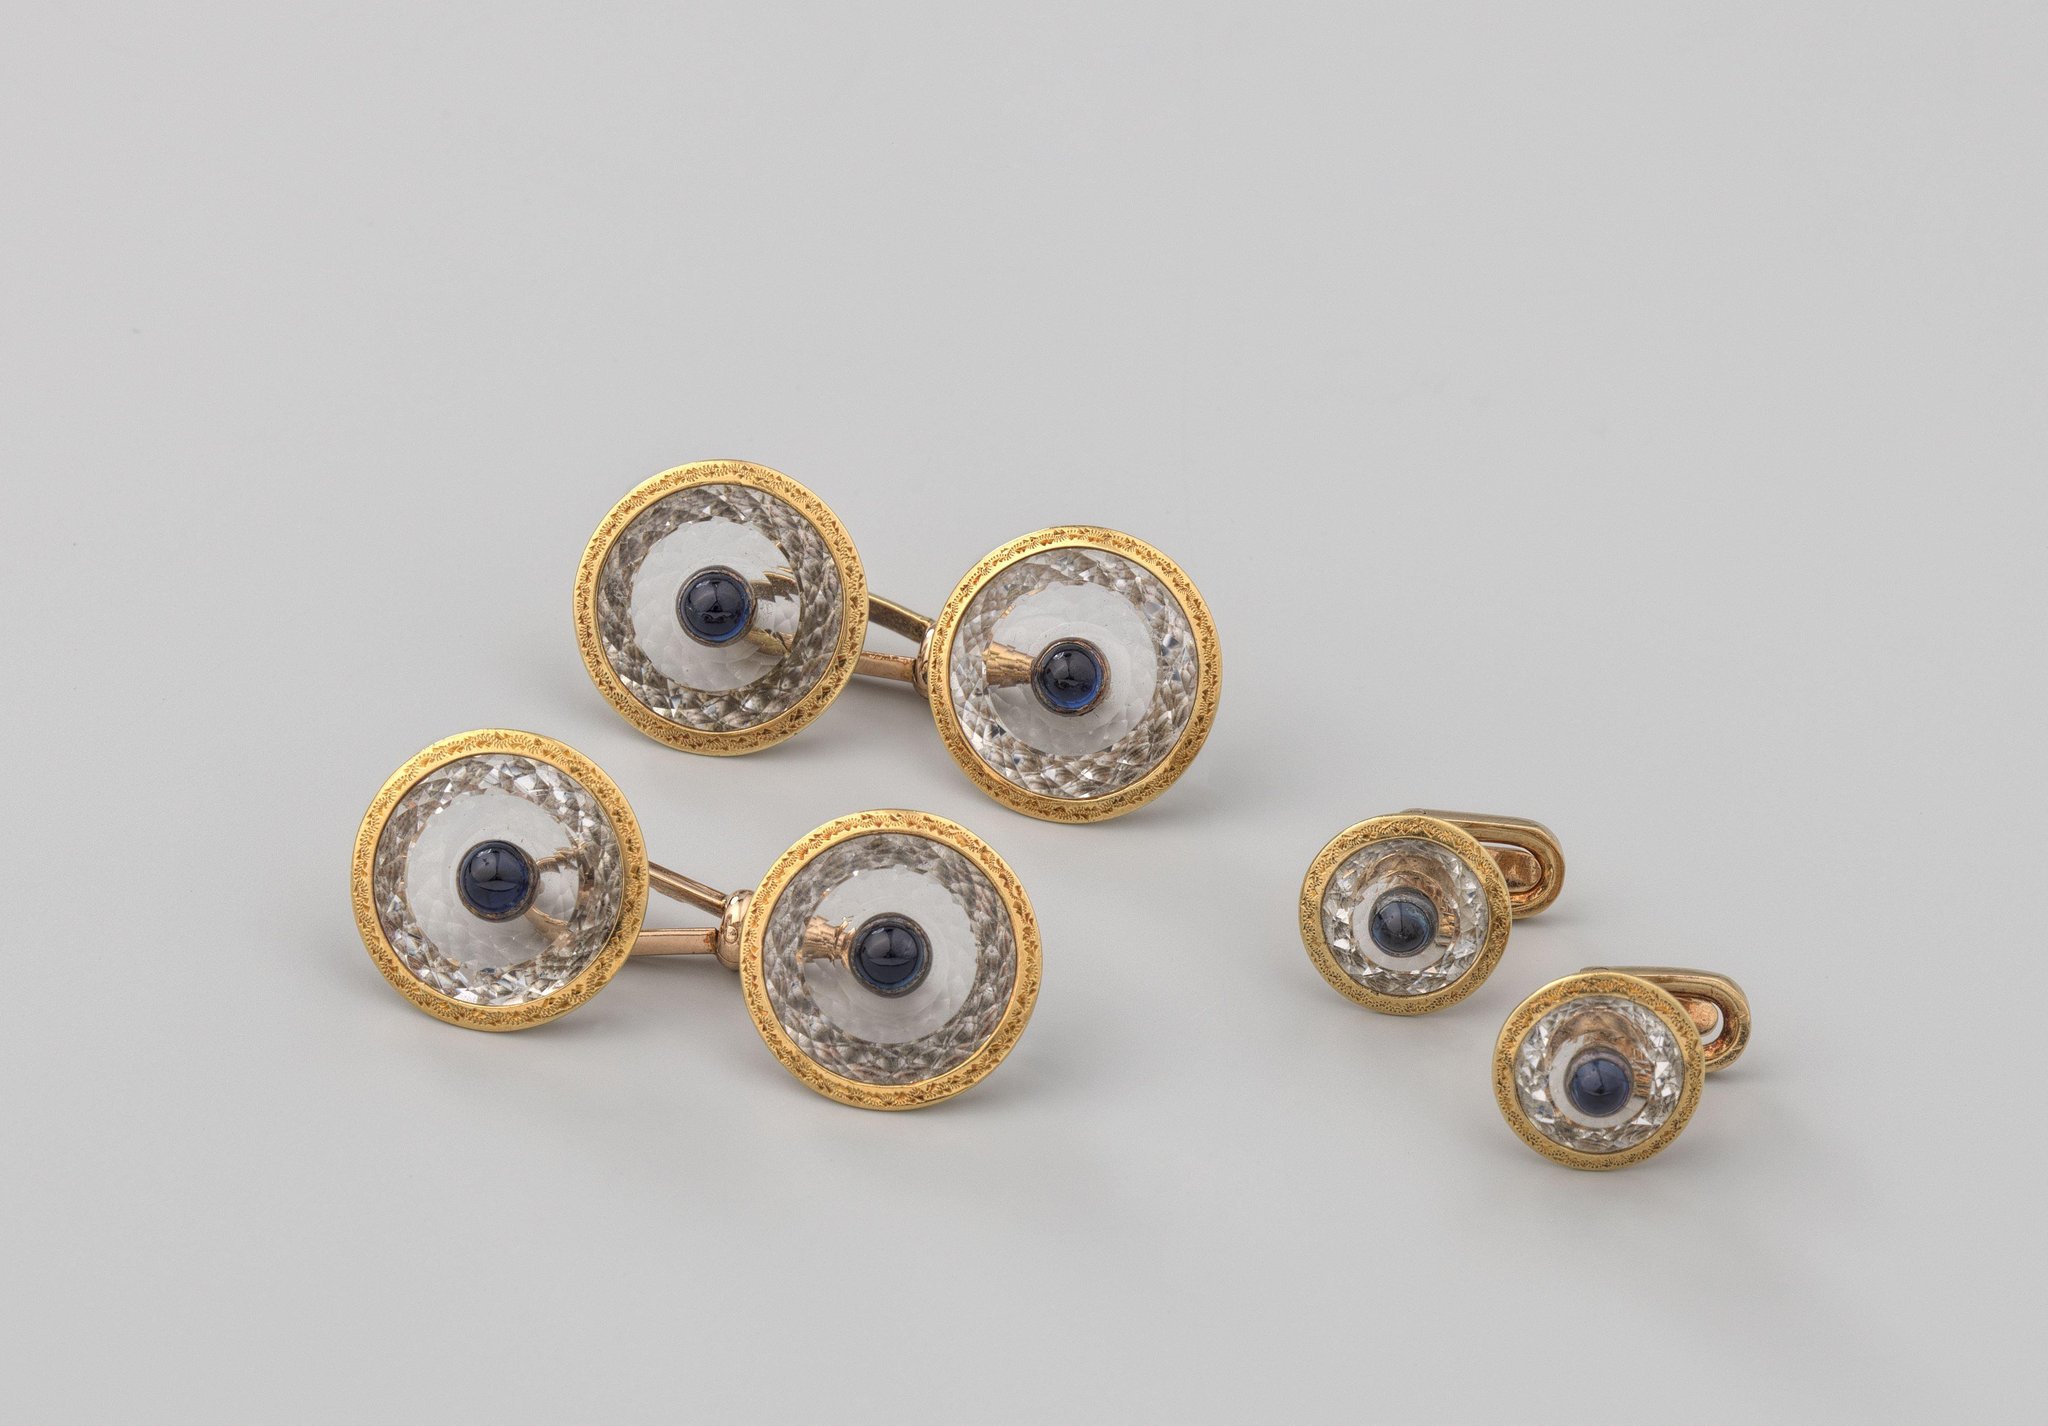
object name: collar button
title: Paar manchetknopen en twee boordeknopen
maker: Anonymous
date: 1890-1910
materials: gold, gemstone, silver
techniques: faceting, grinding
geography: austria-hungary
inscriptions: alloy mark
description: Facet geslepen bergkristallen met blauwe saffieren gezet in goud en zilver.